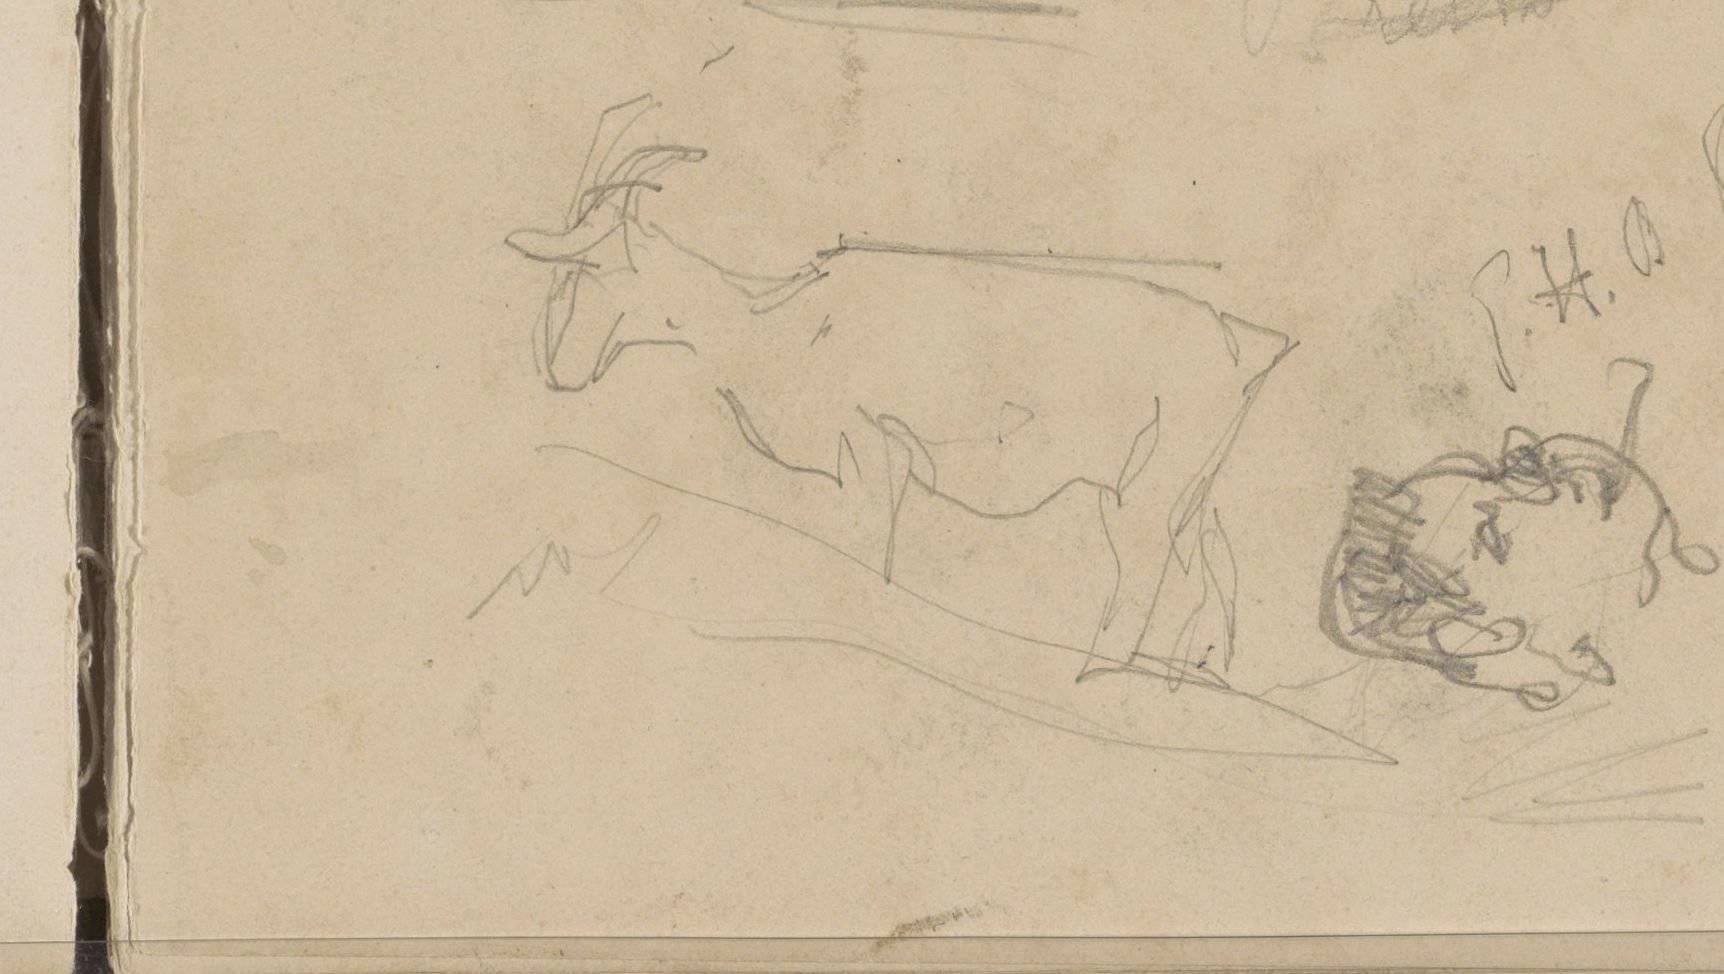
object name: sketchbook leaf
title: Geit en een hoofd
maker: george hendrik breitner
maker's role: draughtsman, painter, print maker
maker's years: 1857-1923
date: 1880-1882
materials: paper, pencil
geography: the hague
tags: head (human), goat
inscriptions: workshop stamp: Lugt 291d, monogram: ‘G.H.B.’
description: Blad 4 recto uit een schetsboek met 16 bladen.